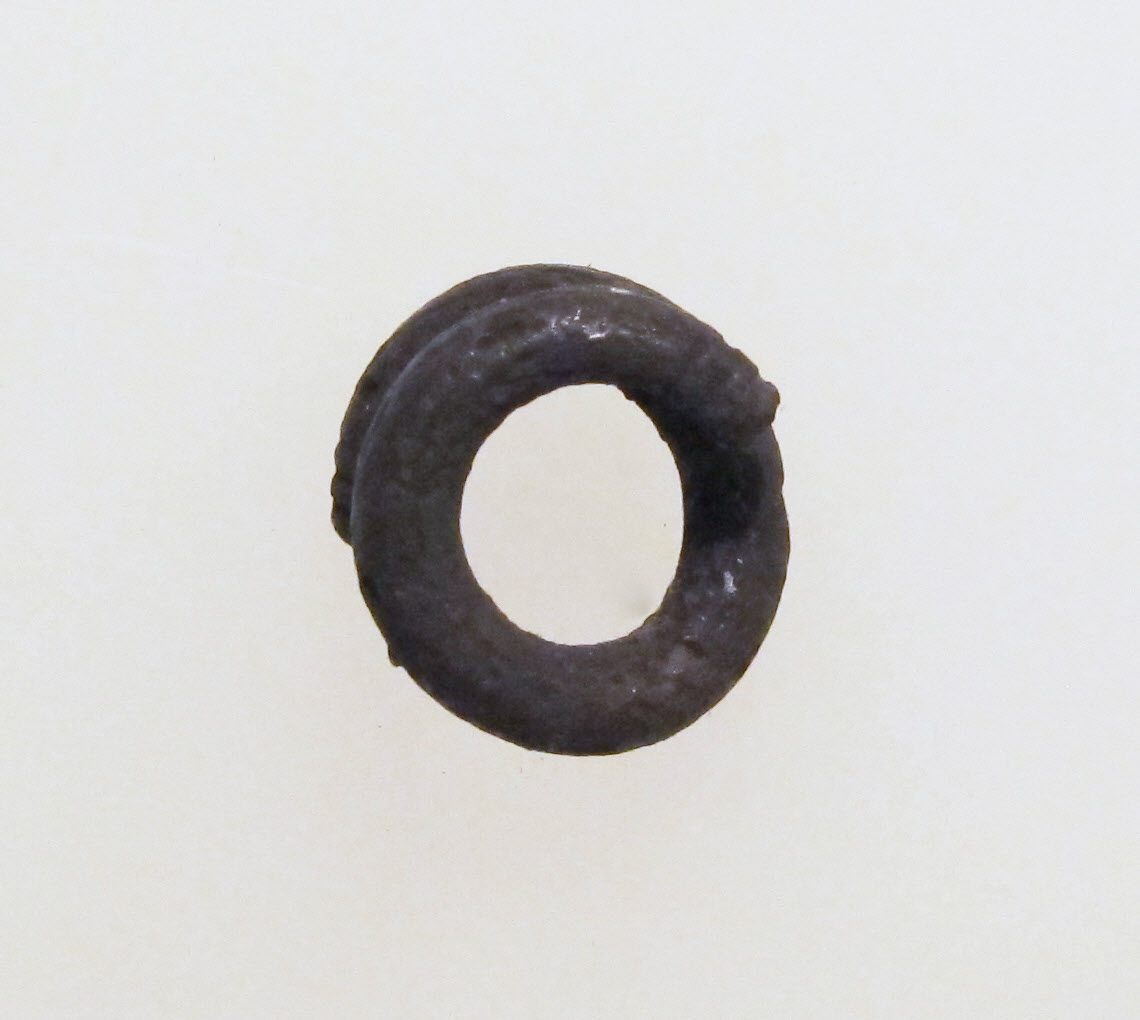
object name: earring or spiral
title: Silver earring or spiral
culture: cypriot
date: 500-401 BCE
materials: silver